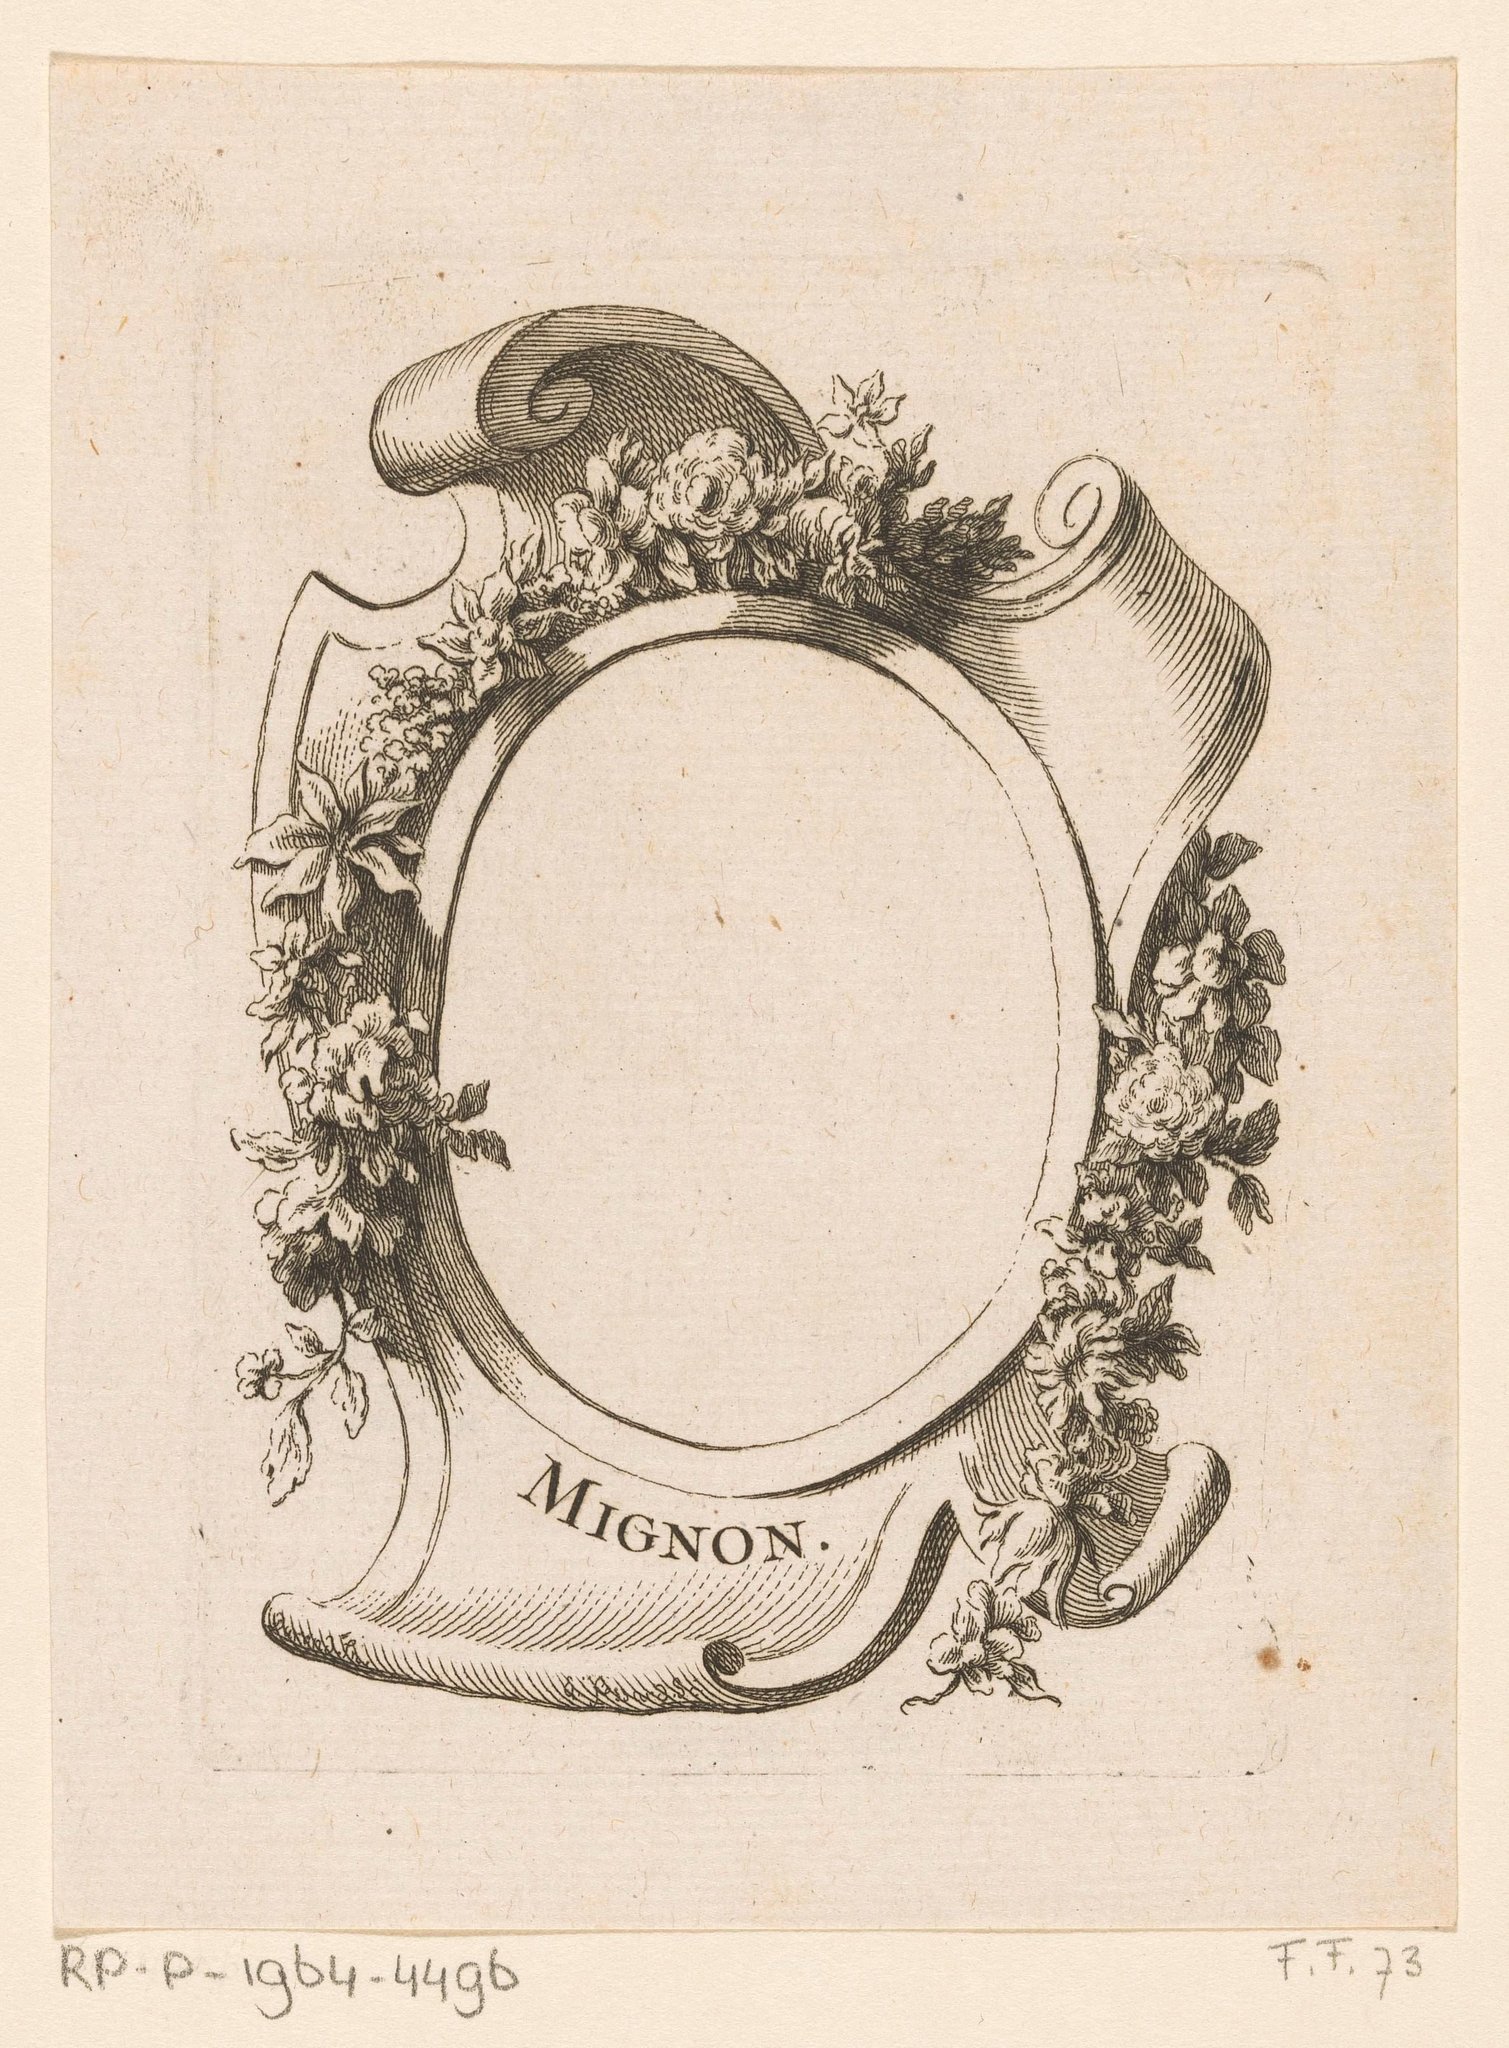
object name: print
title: Omlijstingen voor kunstenaarsportretten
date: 1724-1777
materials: paper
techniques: etching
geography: france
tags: ornaments ~ art (+ framing decorations), artist (in general)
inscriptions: collector's mark: Lugt 2228, collector's mark: Lugt 2760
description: Een ovale omlijsting met bloemen voor Mignon (Abraham Mignon).